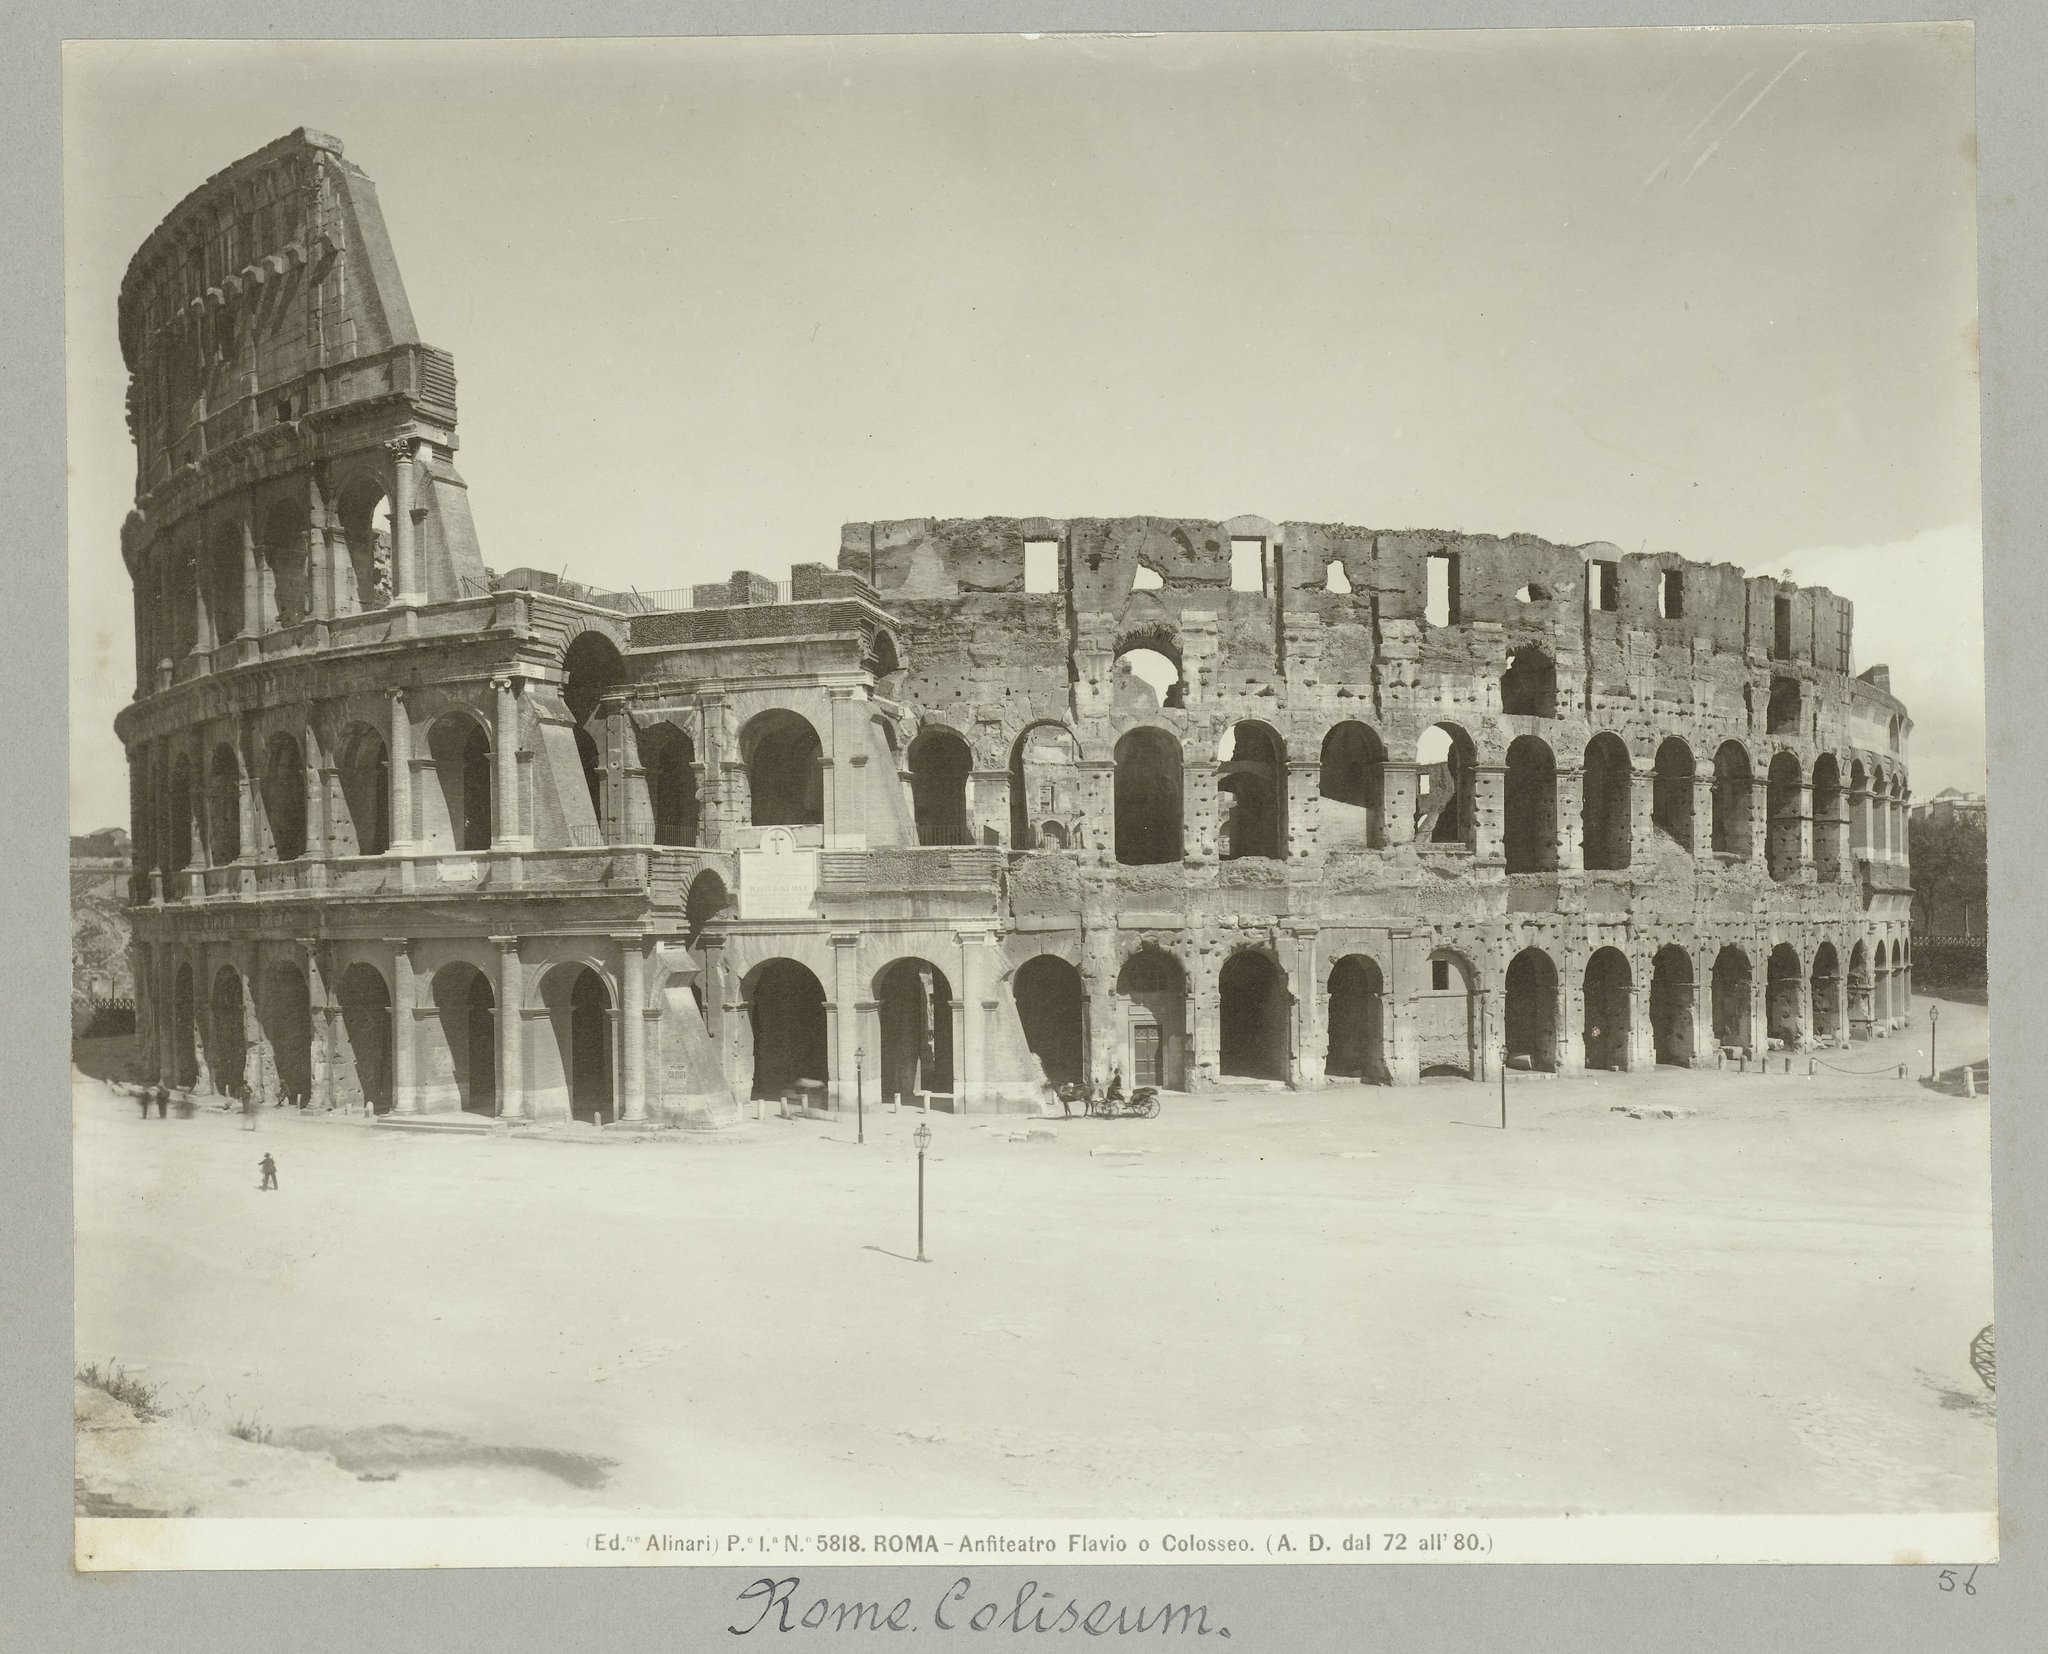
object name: photograph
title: P.I.N. 5818 Roma Amfiteatro flavio o colosseo (A.D. dell 72 all' 80).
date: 1893-1903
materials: cardboard, photographic support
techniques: albumen print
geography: netherlands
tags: colosseum